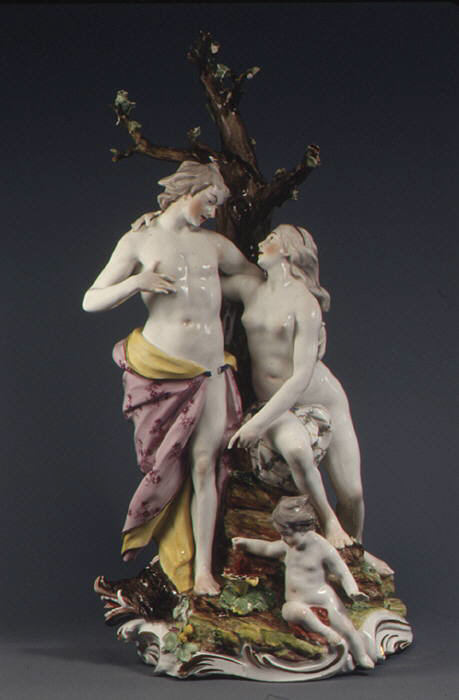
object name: group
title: Meleager and Atalanta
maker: frankenthal porcelain manufactory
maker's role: manufactory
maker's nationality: german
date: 1777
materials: hard paste porcelain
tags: children,men,female nudes,boars